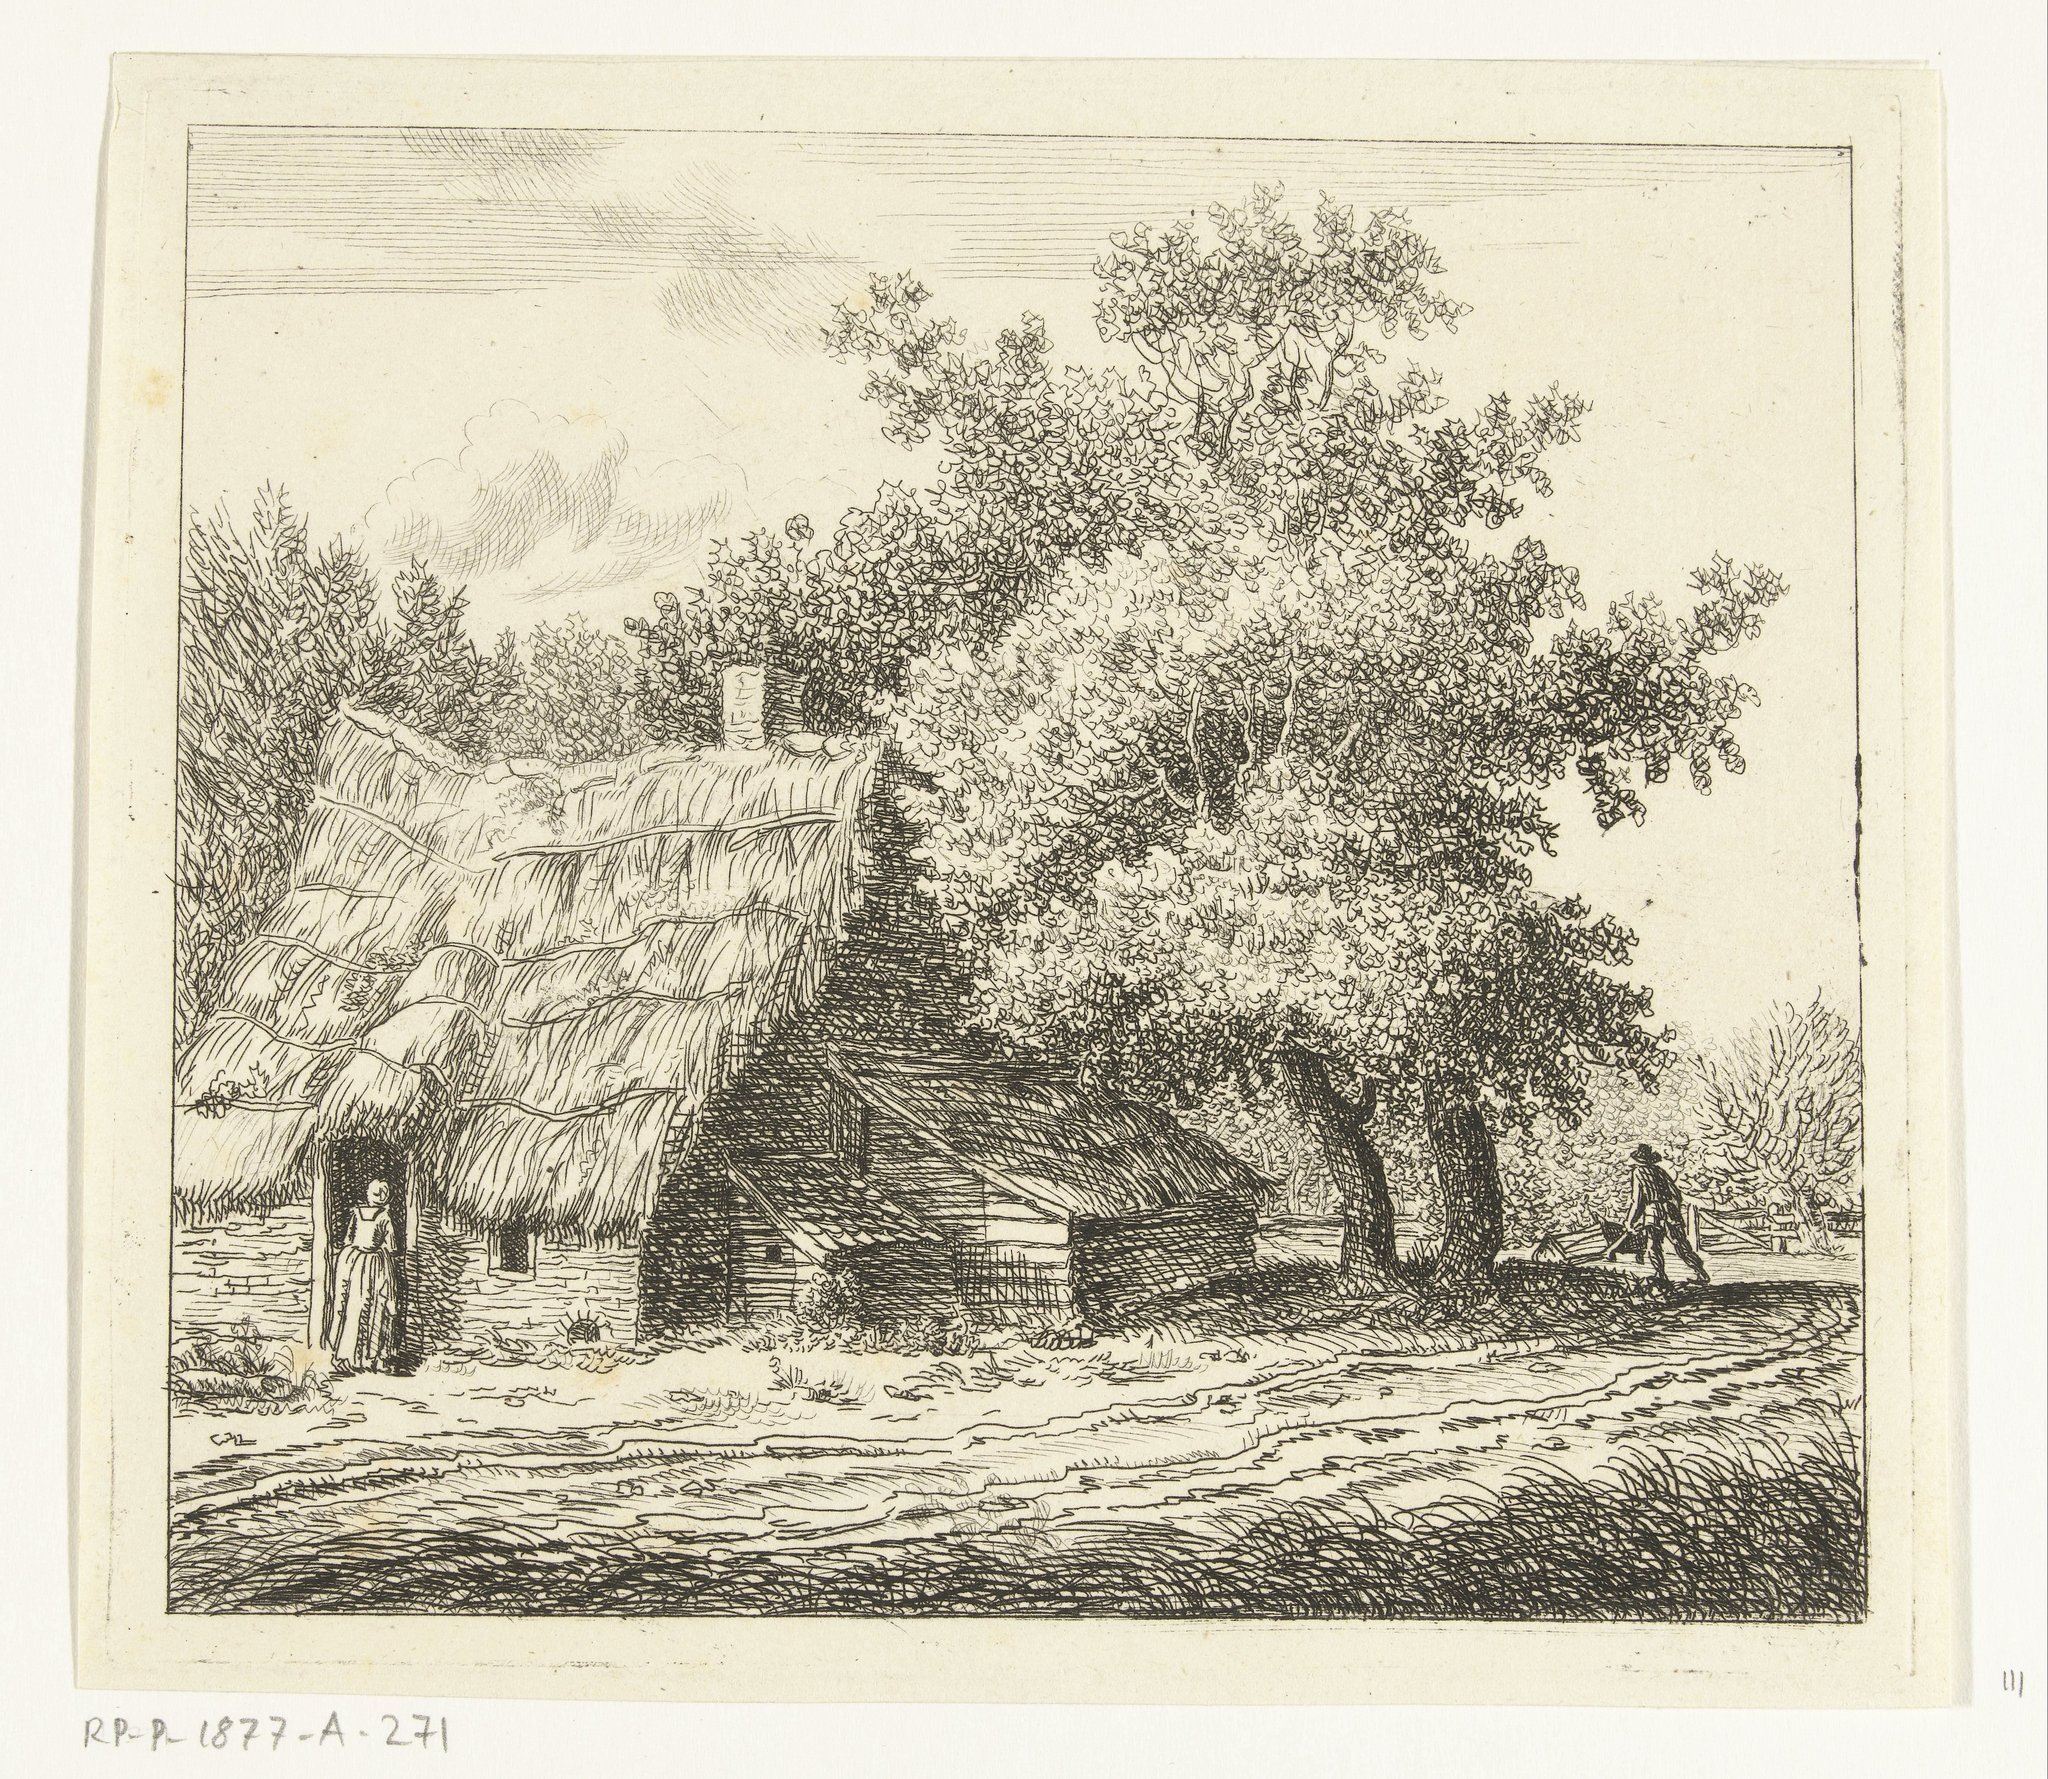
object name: print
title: Boerderij met vrouw bij de deur en een man met kruiwagen op een pad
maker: anthonie van den bos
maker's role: draughtsman, print maker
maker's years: 1763-1838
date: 1778-1838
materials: paper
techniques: etching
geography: netherlands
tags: farm or solitary house in landscape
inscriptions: collector's mark: Lugt 2228